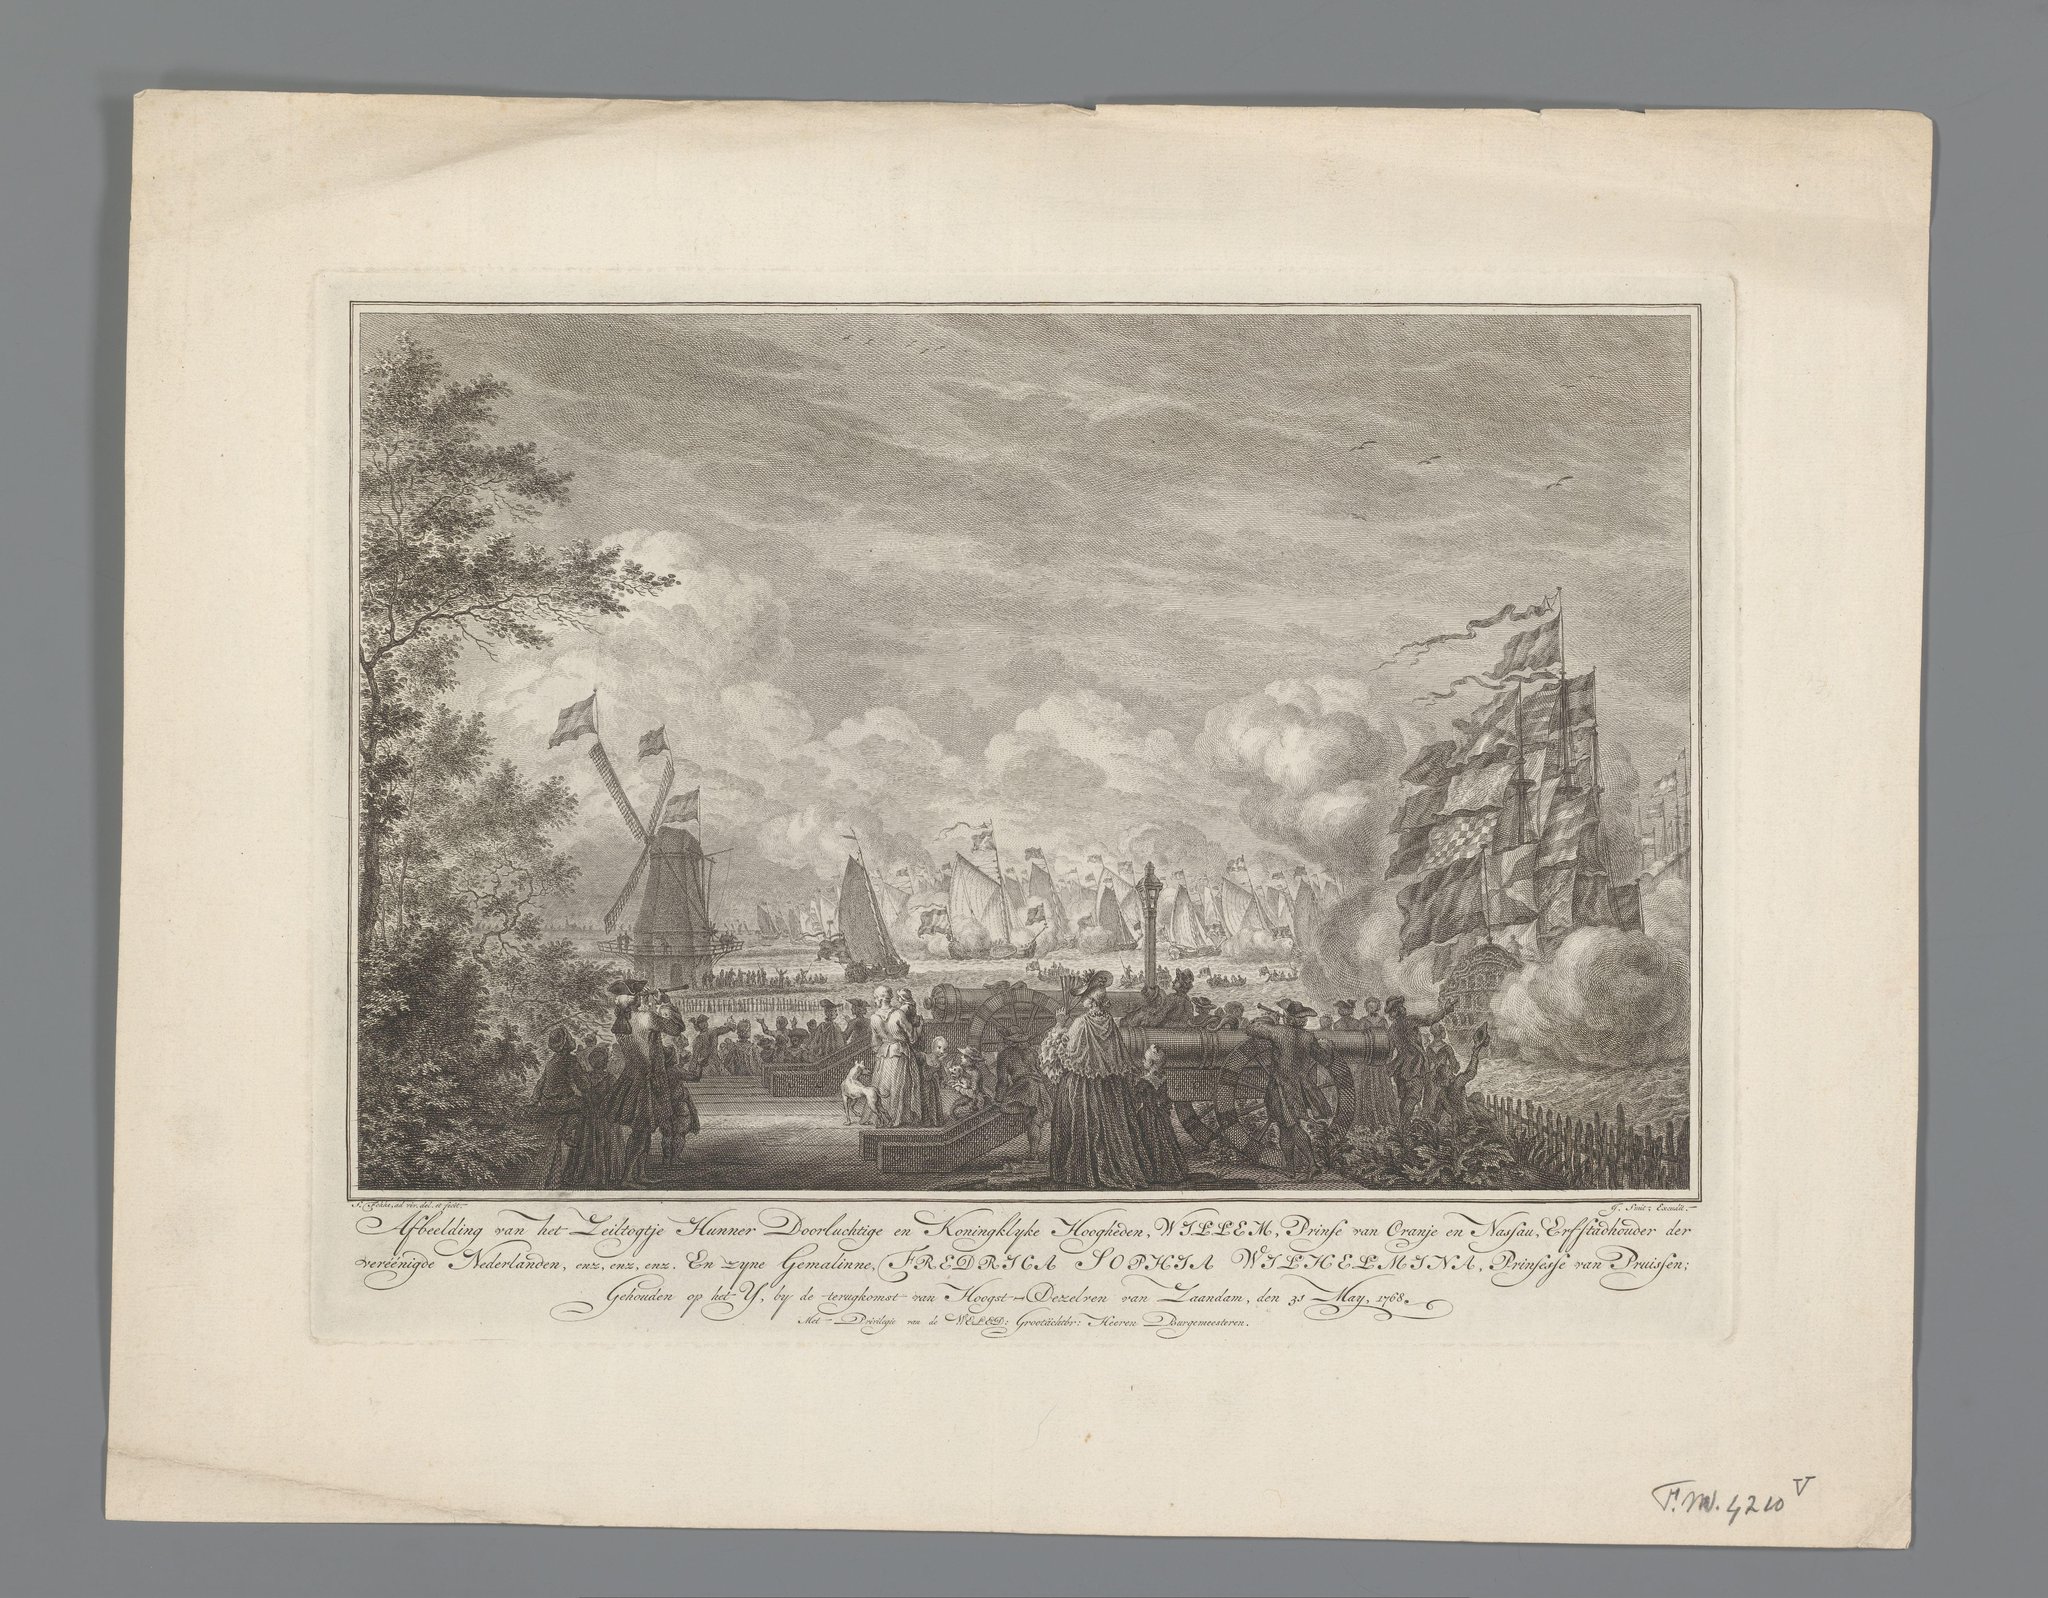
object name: print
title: Zeiltocht van Willem V en Wilhelmina van Pruisen op het IJ, 1768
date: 1769-1773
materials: paper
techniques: engraving, etching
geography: northern netherlands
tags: the hague, william v (prince of orange), berlin, painter, draughtsman, wilhelmina of prussia (princess of orange), public festivities on the occasion of royal events - aa - festivities on the water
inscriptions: collector's mark: Lugt 2233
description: Zeiltocht van stadhouder Willem V en prinses Wilhelmina van Pruisen op het IJ bij terugkomst uit Zaandam, op 31 mei 1768. Gezicht op de vele scheepjes op het water, met toeschouwers bij kanonnen op de kade. Onderdeel van een prentserie met titelprent en veertien platen van de inhaling van de prins en prinses te Amsterdam, 30 mei - 4 juni 1768.